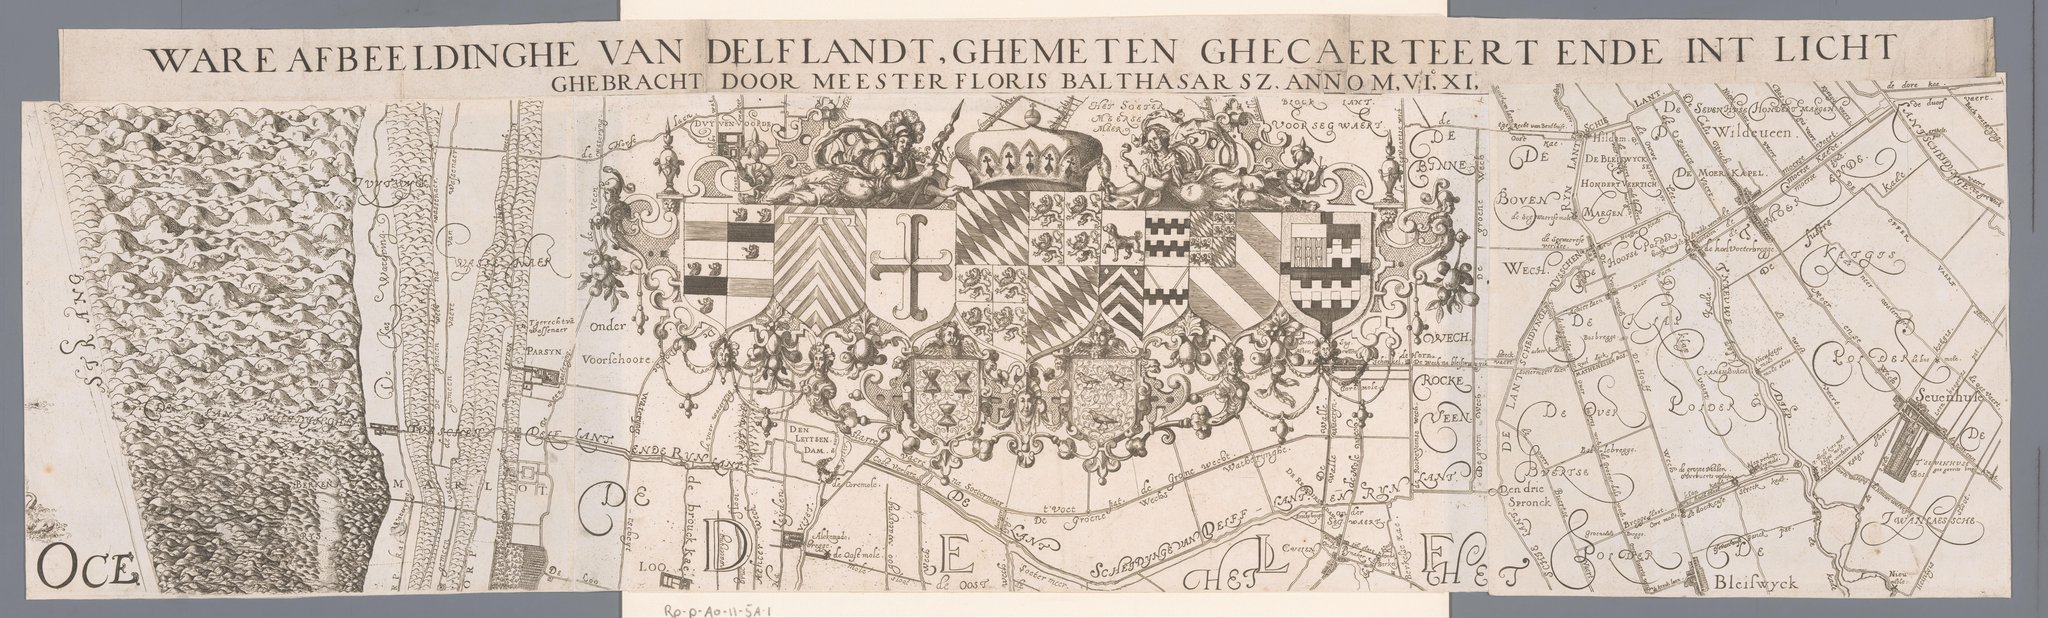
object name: print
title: Ware afbeeldinghe van Delflandt, ghemeten ghecaerteert ende int licht ghebracht (...)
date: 1611-1692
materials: paper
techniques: engraving, etching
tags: maps of separate countries or regions, armorial bearing, heraldry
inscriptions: collector's mark: Lugt 195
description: Met de wapens van de leden van het Hoogheemraadschap van Rijnland.